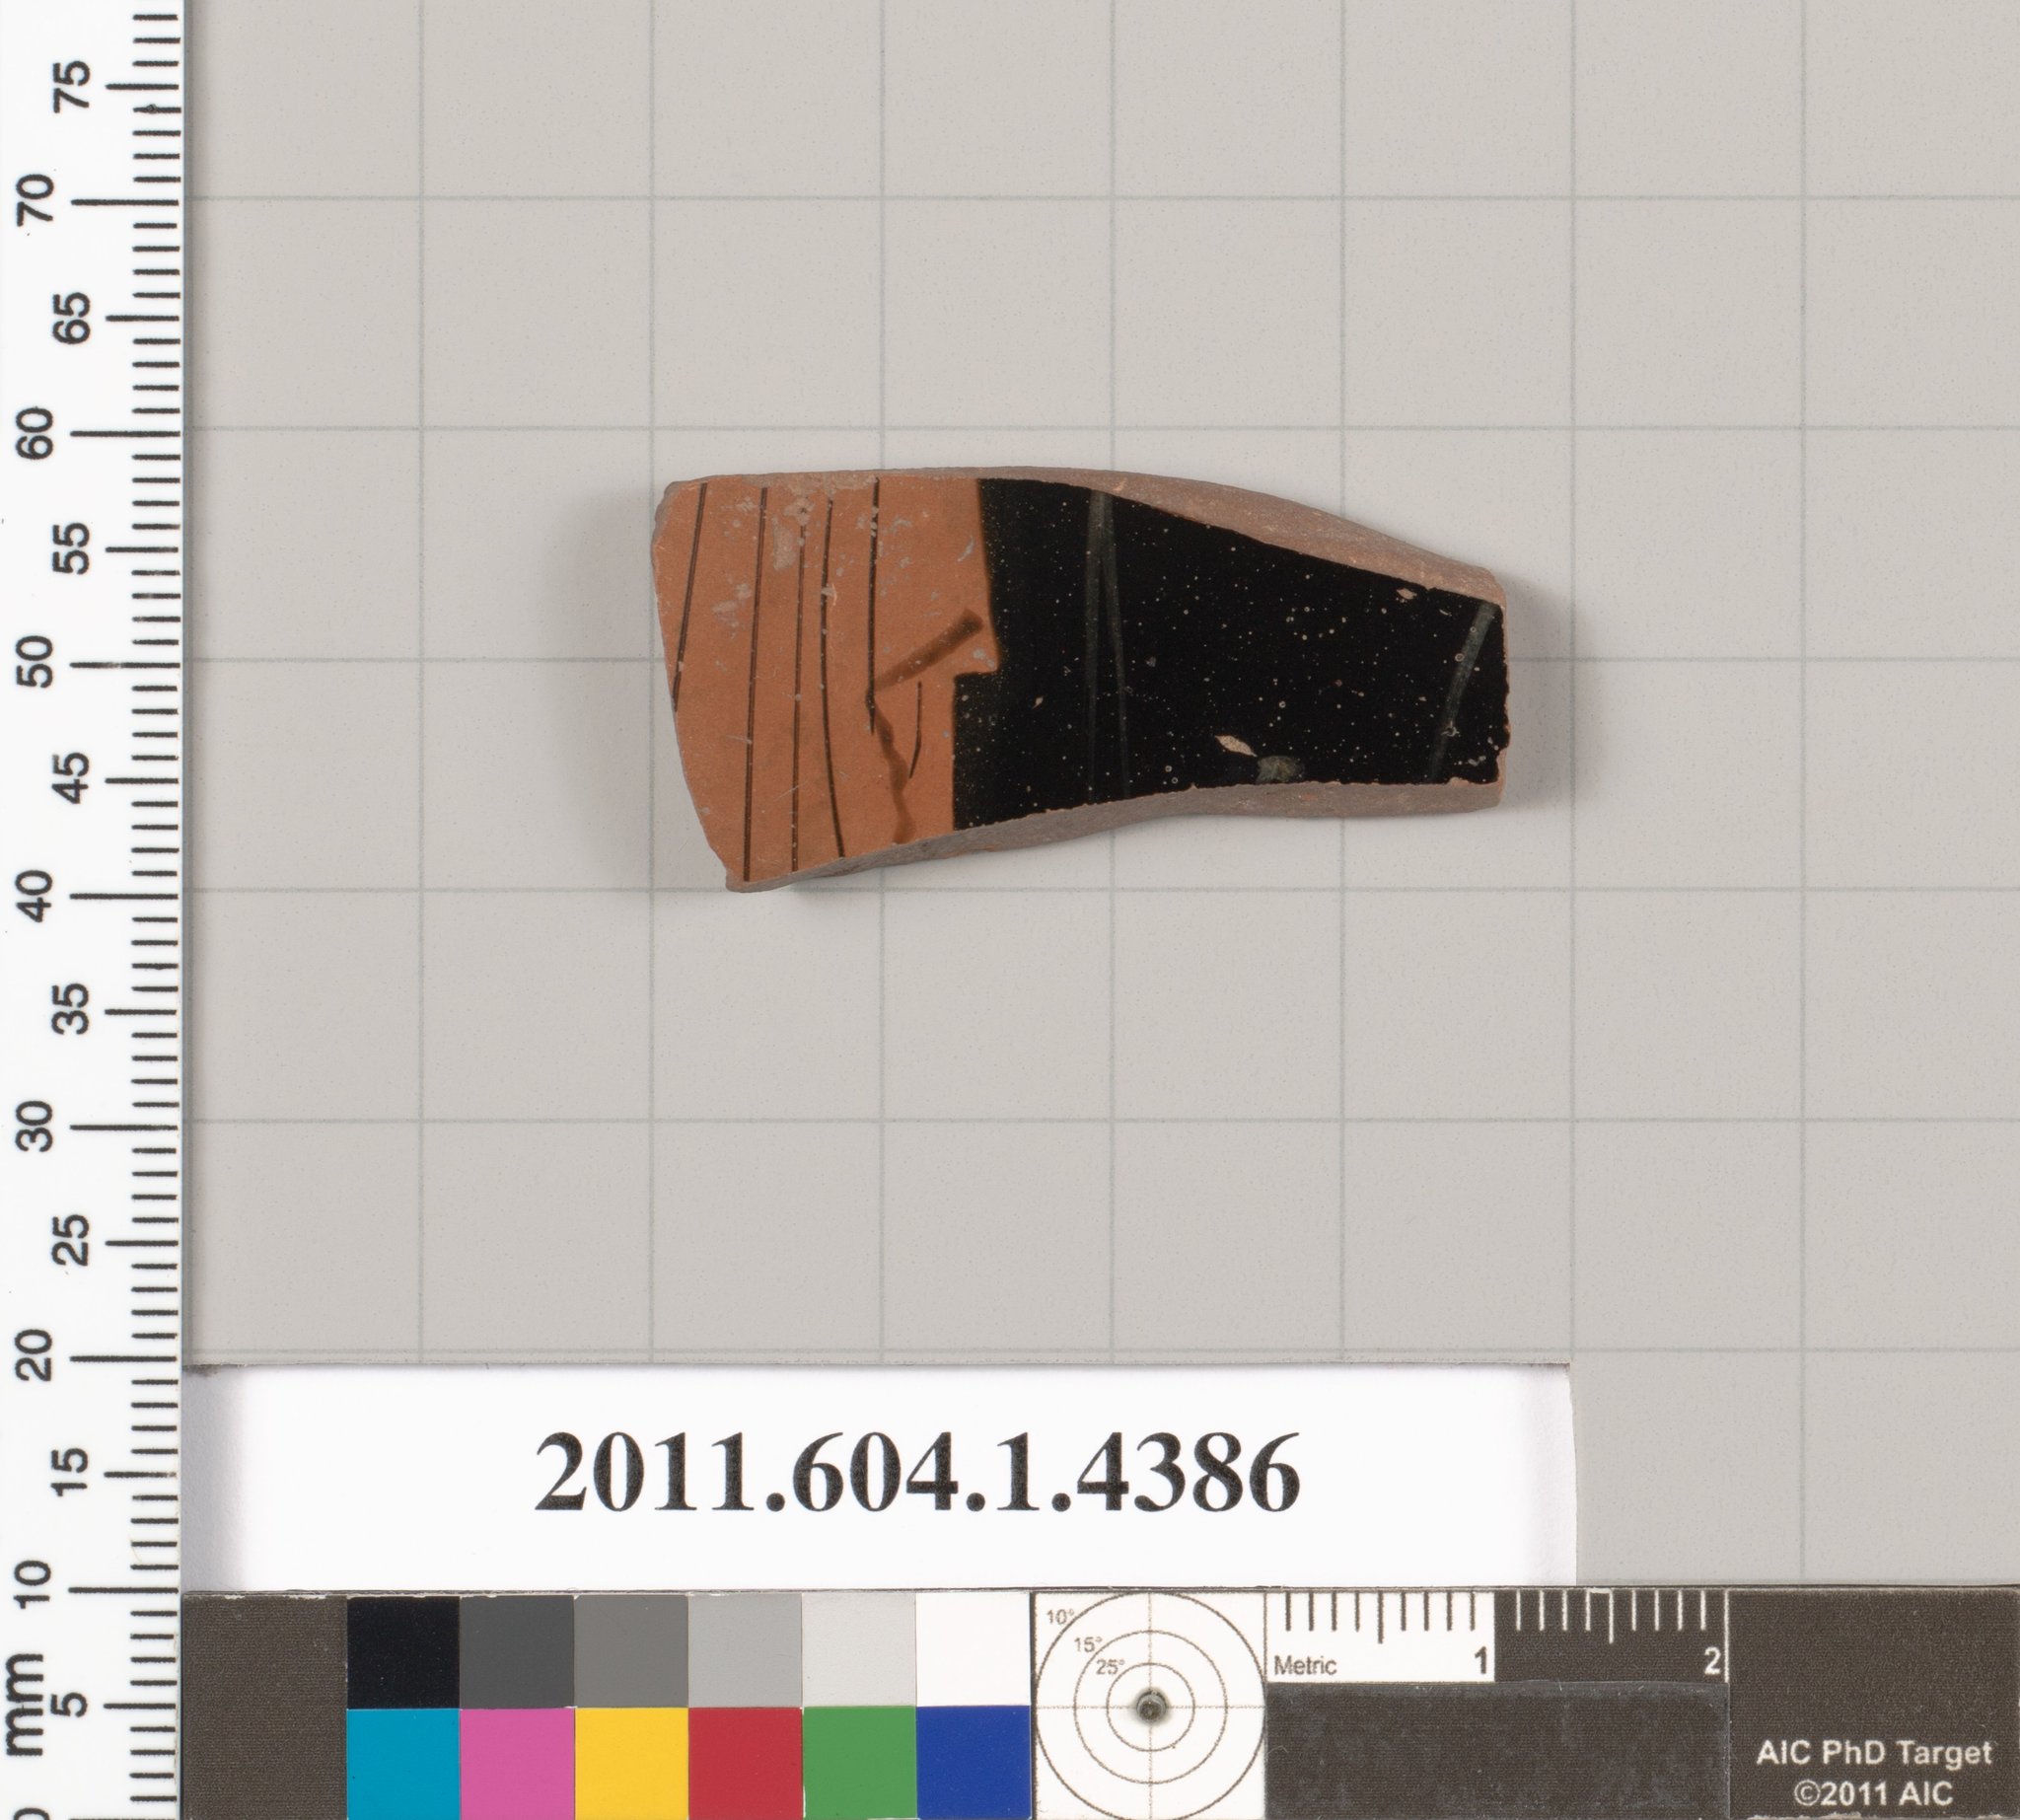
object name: kylix fragment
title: Terracotta fragment of a kylix (drinking cup)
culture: greek, attic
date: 475-451 BCE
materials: terracotta